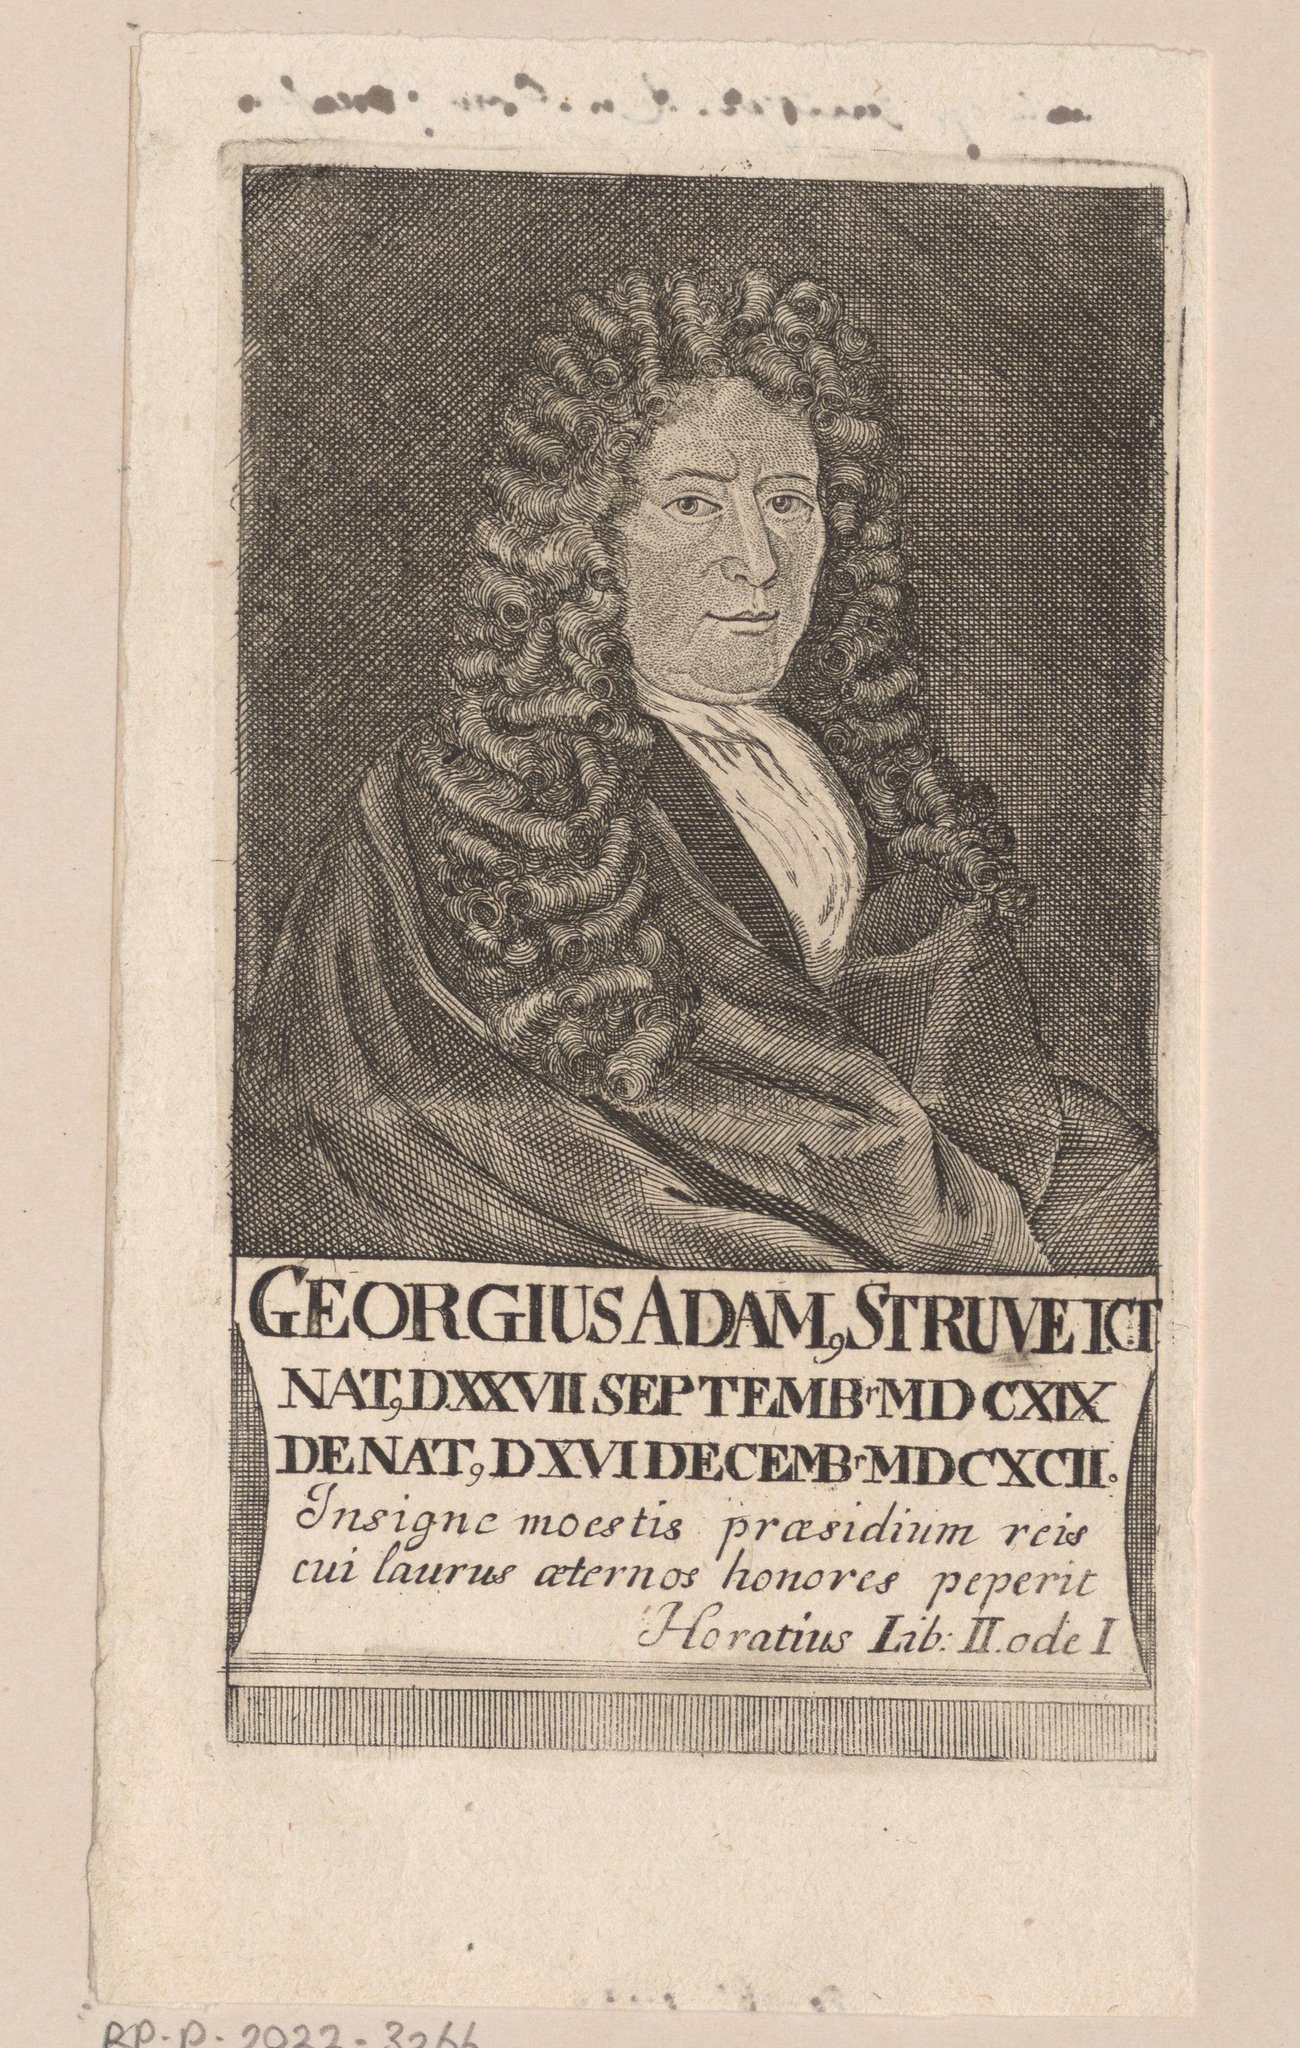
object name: print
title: Portret van Georg Adam Struve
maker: Anonymous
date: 1739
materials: paper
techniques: engraving, etching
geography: germany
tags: historical persons, lawyer, attorney at law, professor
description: Prent mogelijk uit: Struve, Georg Adam. Iurisprudentia Romano-germanica forensis. 16de druk. Frankfurt: Franciscum Varrentrapp, 1739.